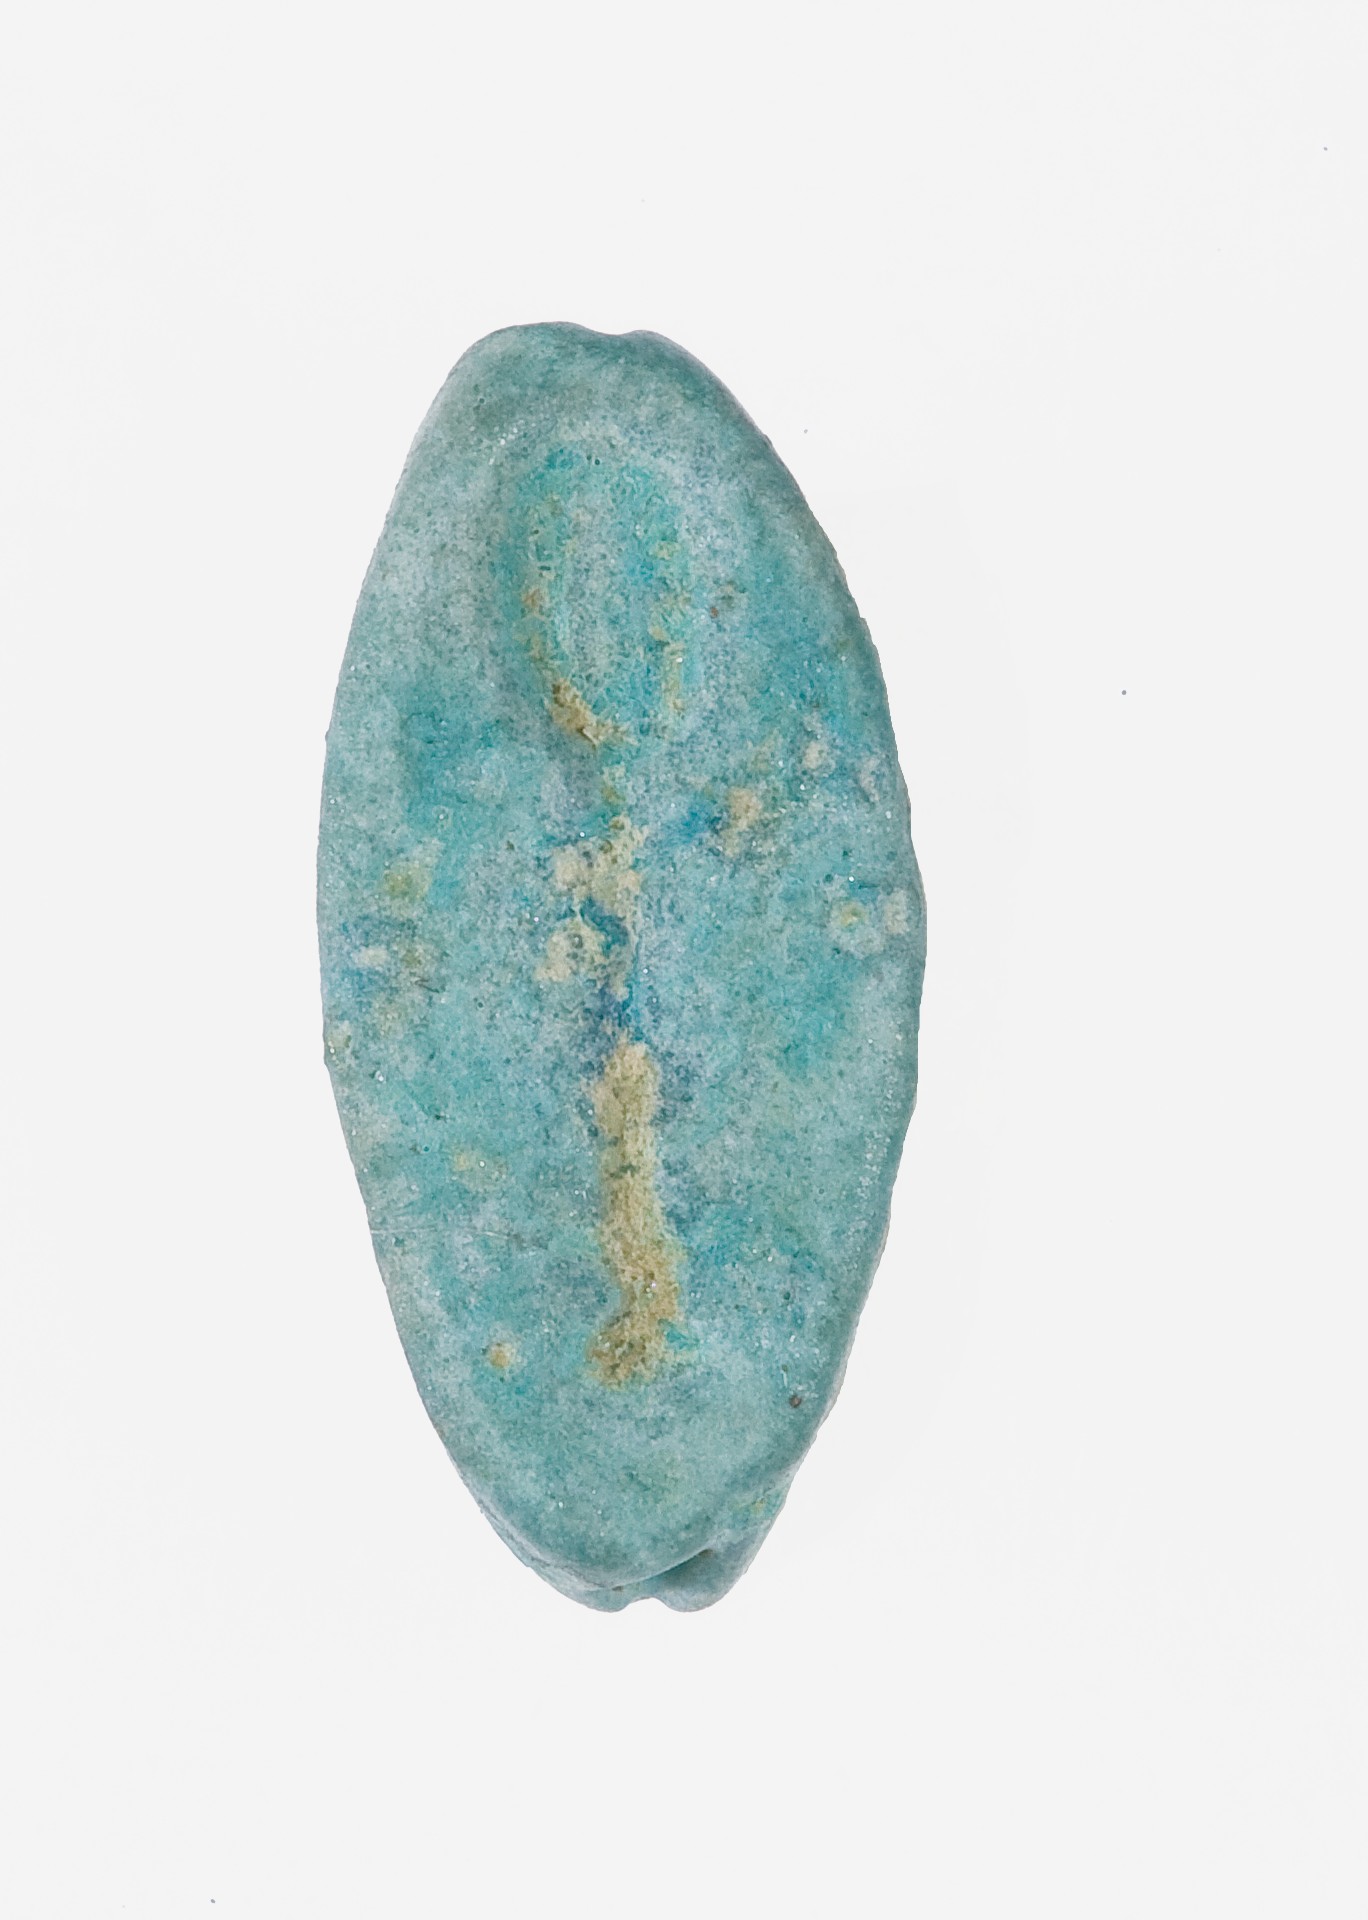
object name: seal, cowroid, nefer inscription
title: Cowroid Seal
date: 1390-1352 BCE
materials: faience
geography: egypt